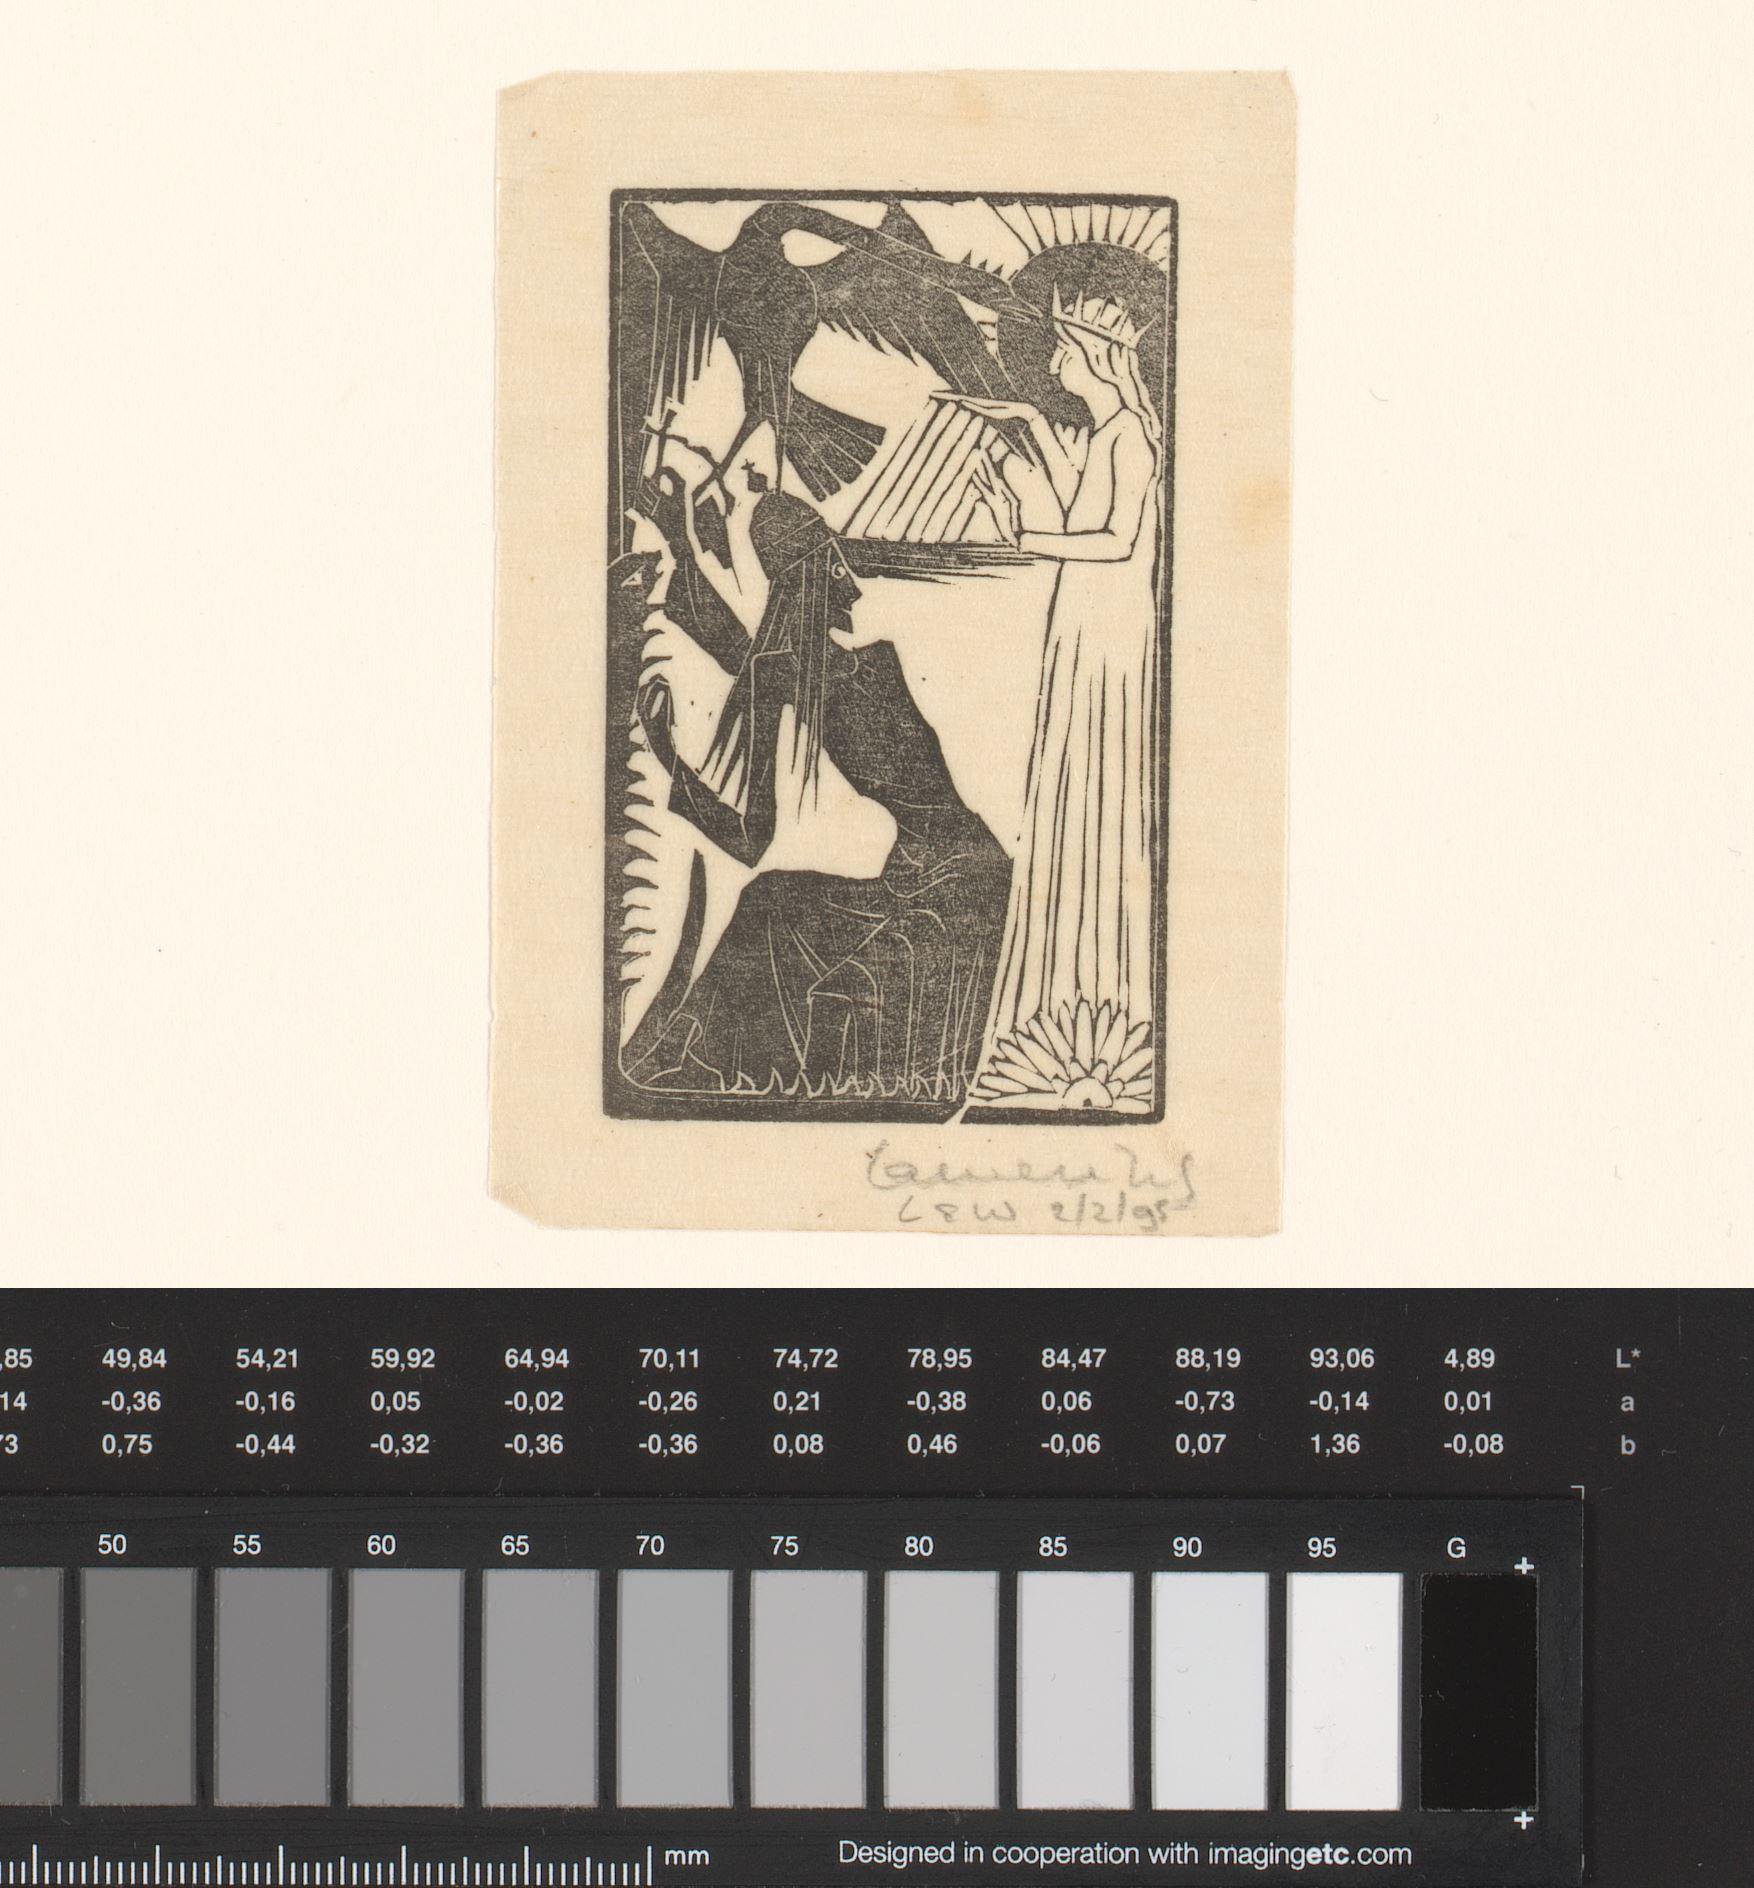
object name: print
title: Twee vrouwen en een vogel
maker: mathieu lauweriks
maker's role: designer, draughtsman, print maker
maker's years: 1864-1932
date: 1895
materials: paper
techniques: woodcut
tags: mouth wide open, water-birds: goose, water-birds: swan, insignia of the pope, e.g. tiara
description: Een knielende vrouw in de muil van een monster met in haar hand een kruis en op haar hoofd een pauselijke tiara. Boven haar hoofd vliegt een vogel, mogelijk een gans of een zwaan. Naast haar staat een in het wit geklede vrouw op een bloem.